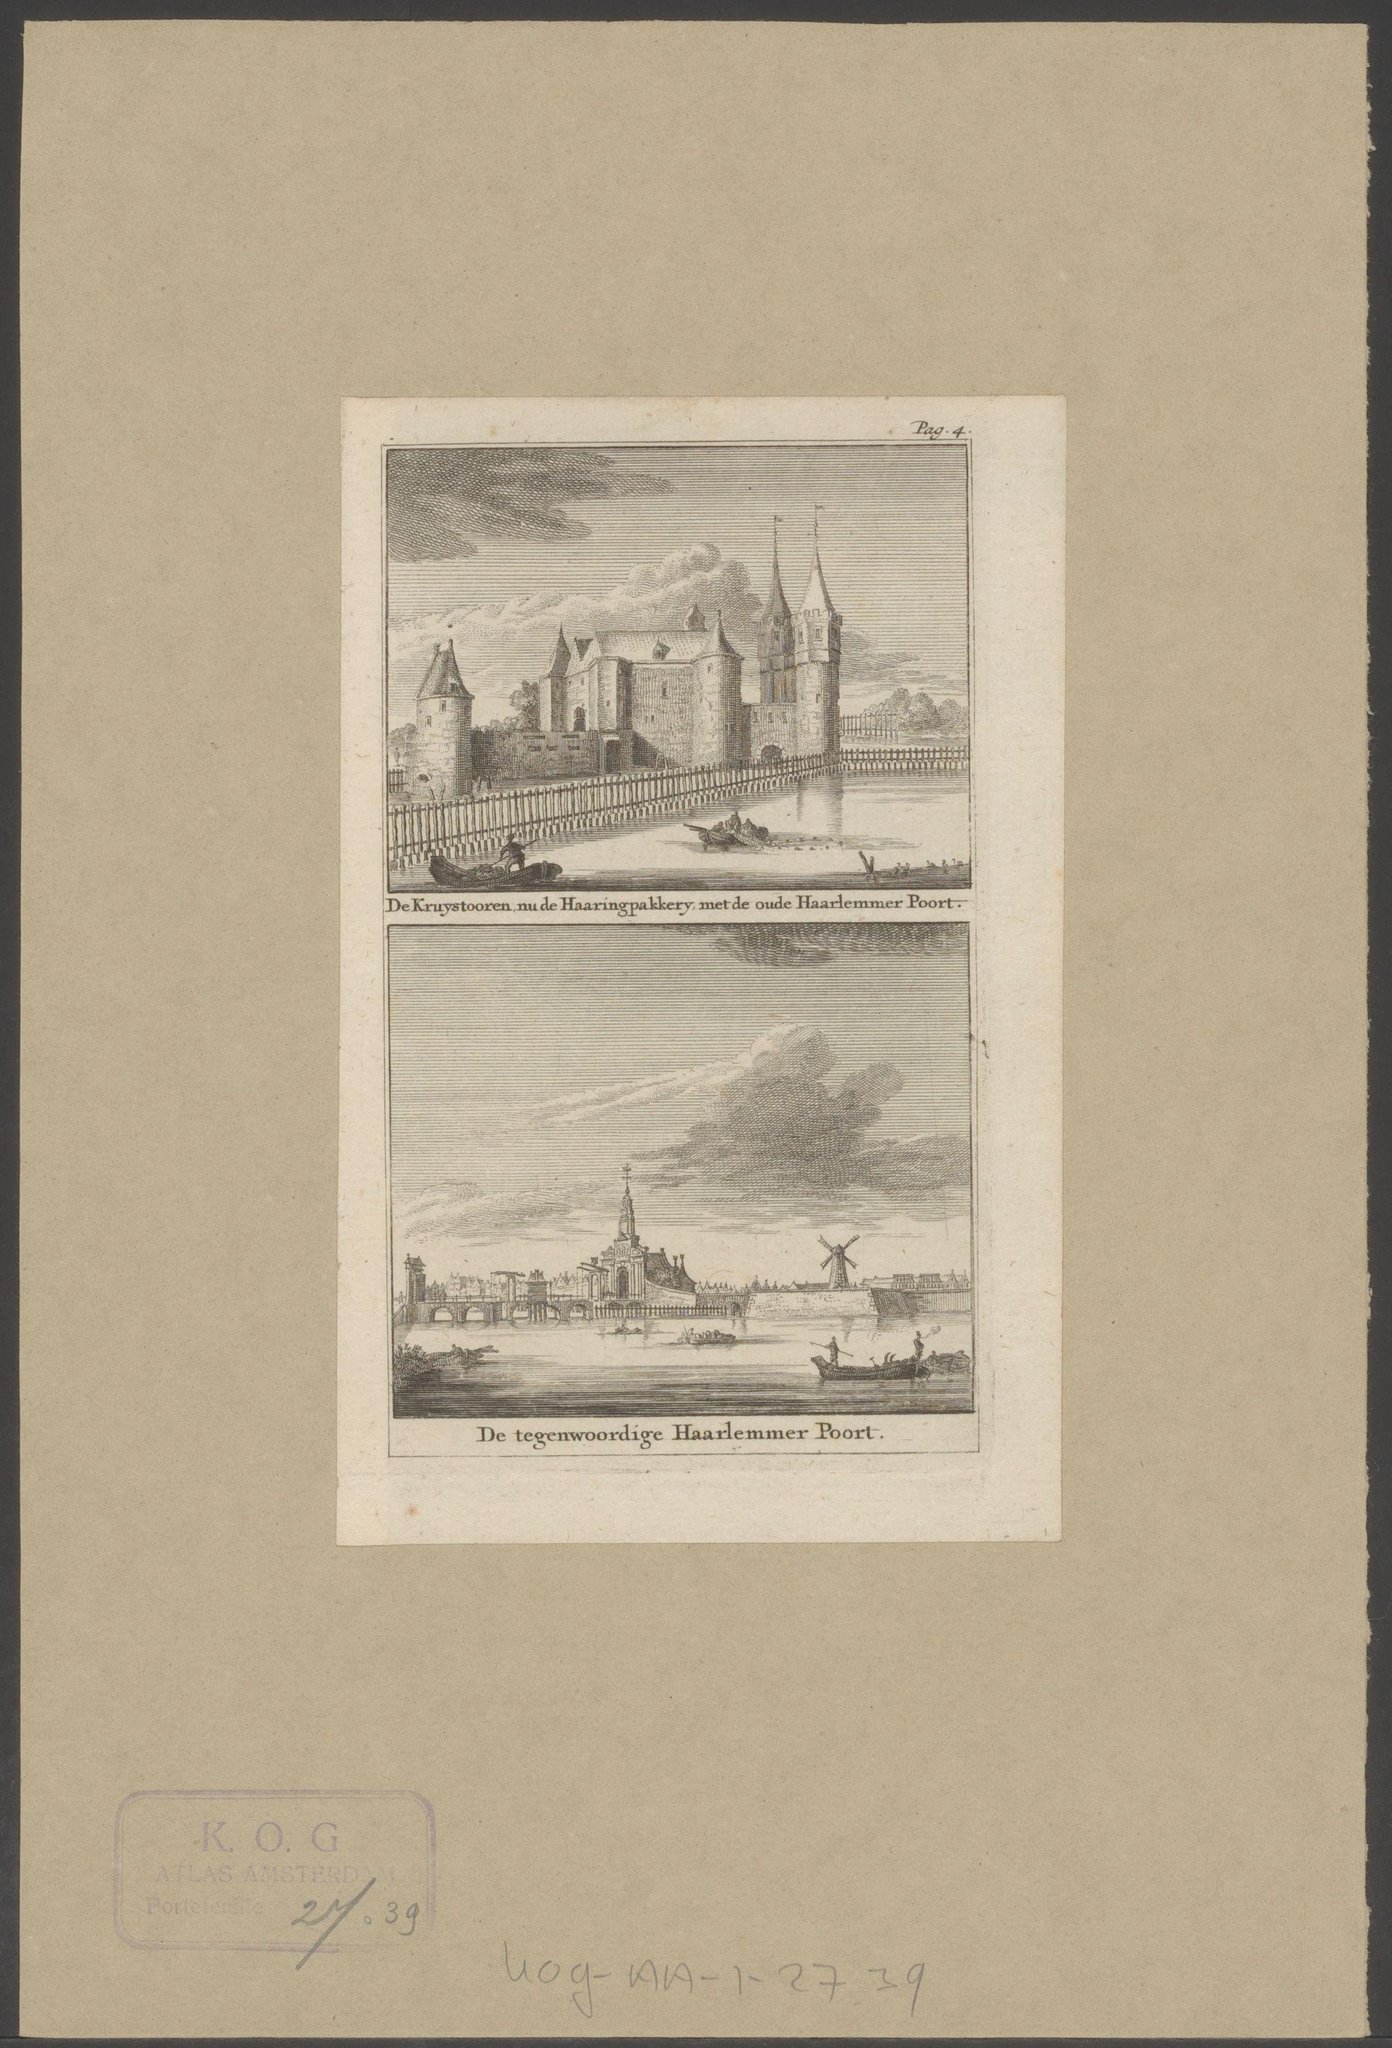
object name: print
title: Gezicht op de Derde en Vierde Haarlemmerpoort te Amsterdam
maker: jan goeree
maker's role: draughtsman, print maker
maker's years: 1670-1731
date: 1723-1738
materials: paper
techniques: engraving, etching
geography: amsterdam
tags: rowing-boat, canoe, etc., city-gate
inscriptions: collector's mark: Lugt 1641b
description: Prent mogelijk uit: Willink, Daniël. Daniël Willinks Amsterdamsche Buitensingel Nevens de omleggende dorpen, opgeheldert door aanteekeningen (…). Amsterdam: Andries van Damme, 1723. Of uit: Willink, Daniël. Daniël Willinks Amsterdamsche Buitensingel, Nevens de omleggende dorpen, opgeheldert door aanteekeningen (…). Amsterdam: Arend van Huyssteen, 1738.